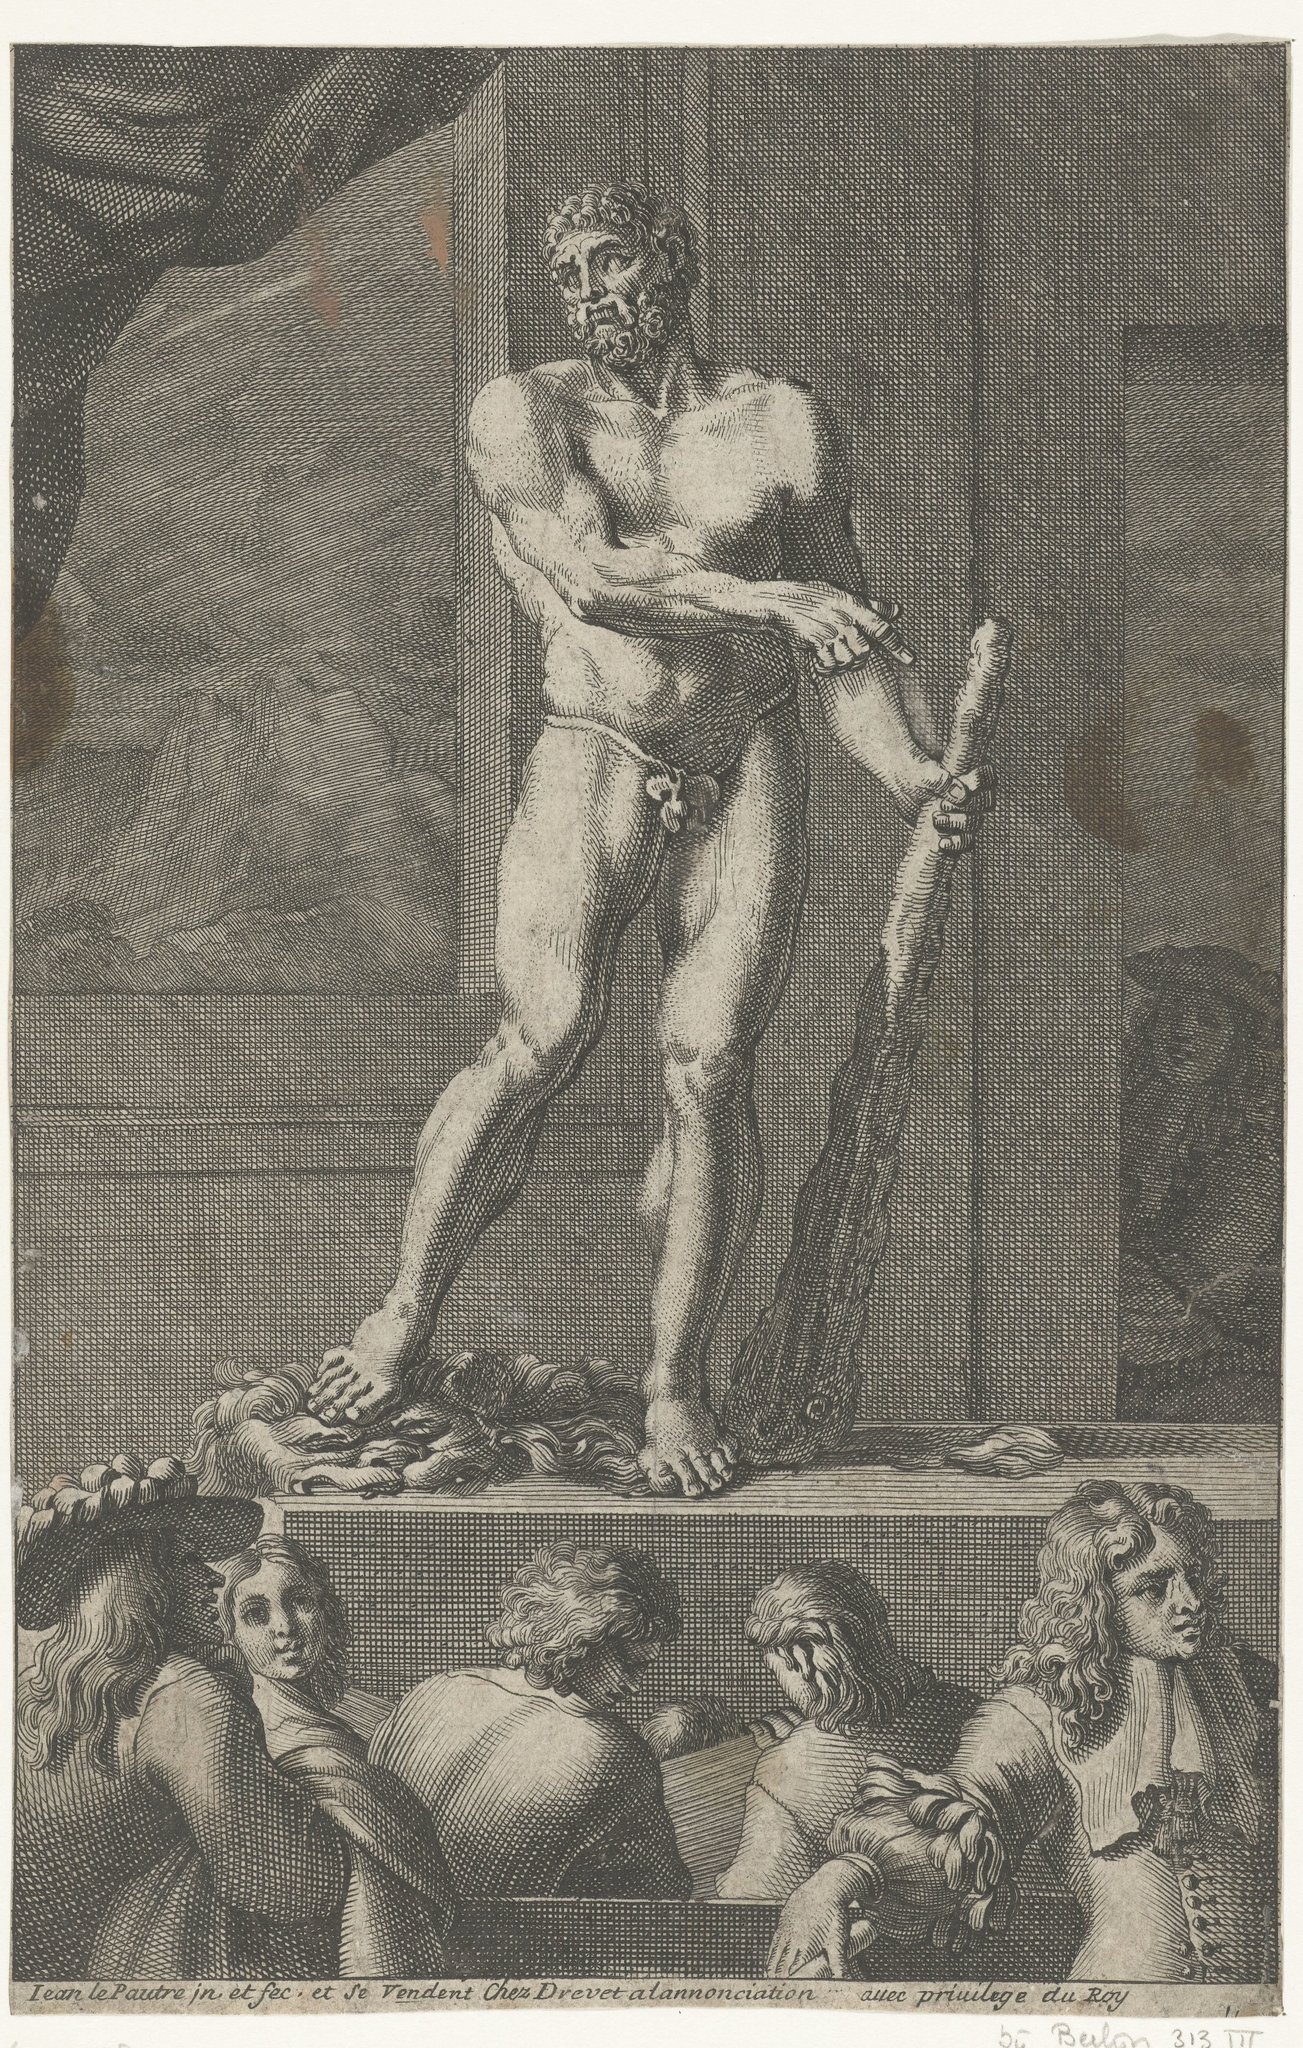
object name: ornament print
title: Liure d'Academie pour apprendre a bien dessigner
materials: paper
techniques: engraving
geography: france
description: Zesde blad uit serie van 6, derde editie.